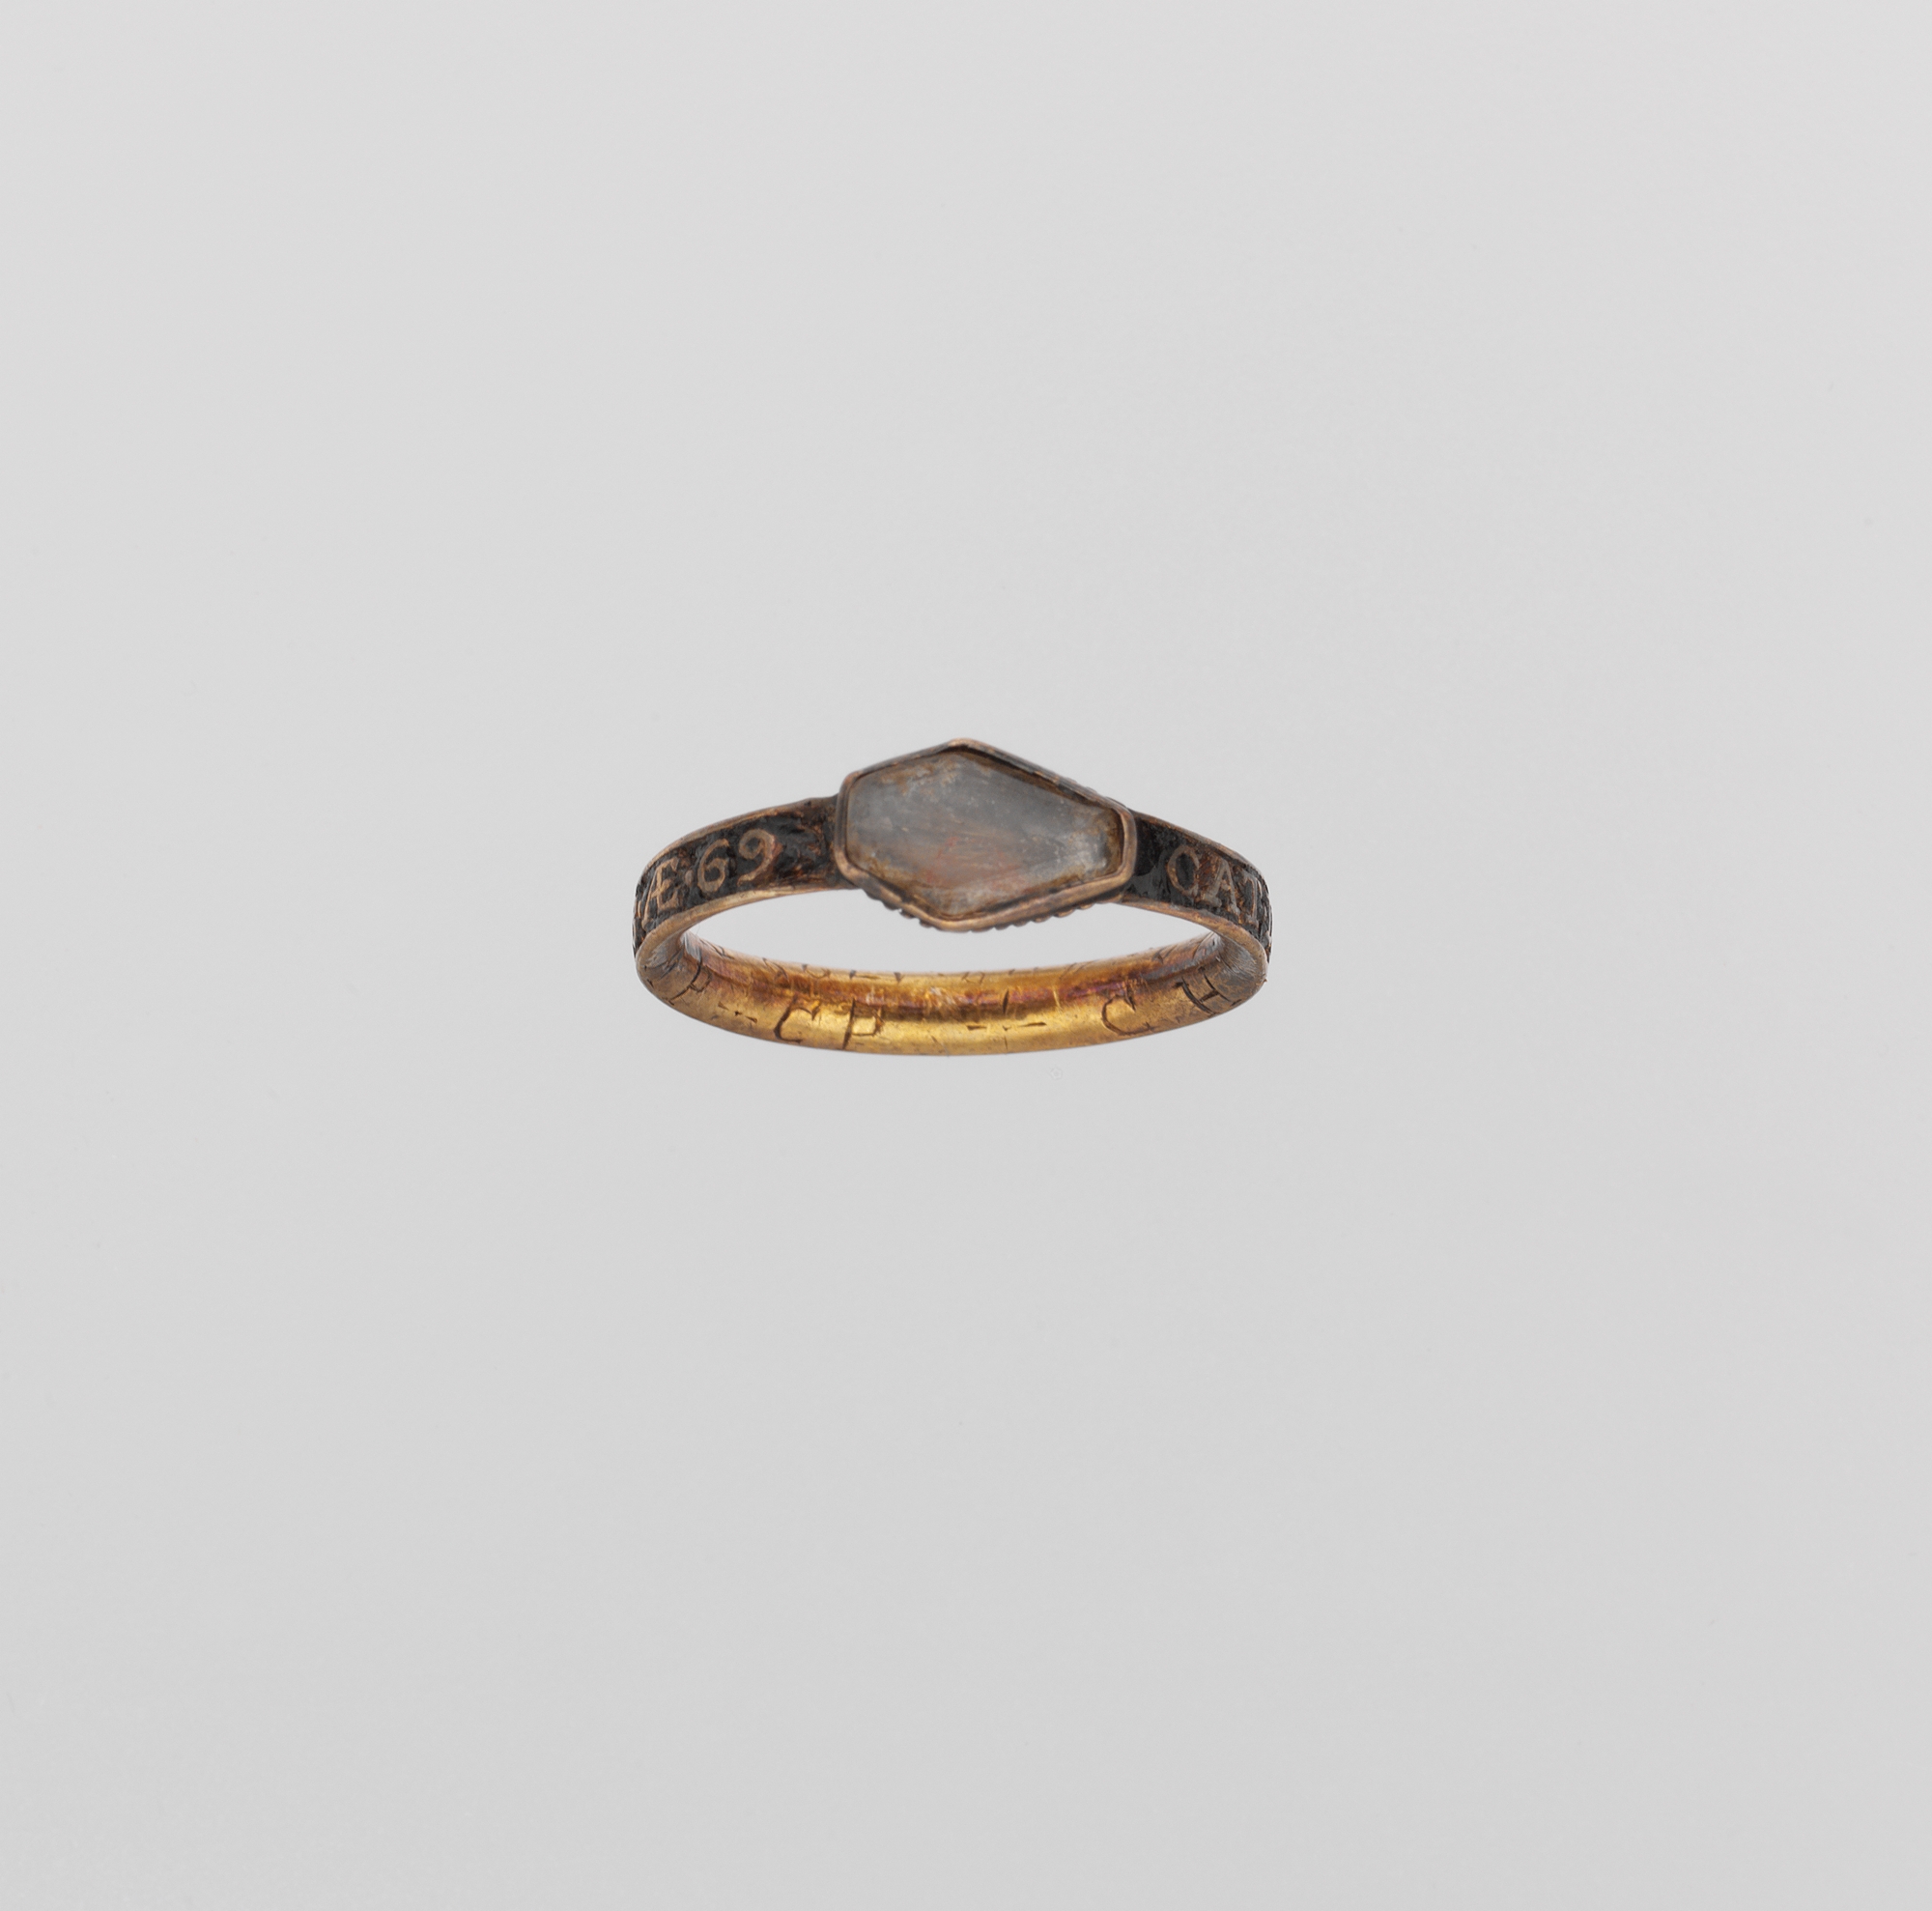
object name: ring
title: Mourning Ring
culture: american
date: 1733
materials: enamel, glass, gold, hair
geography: united states